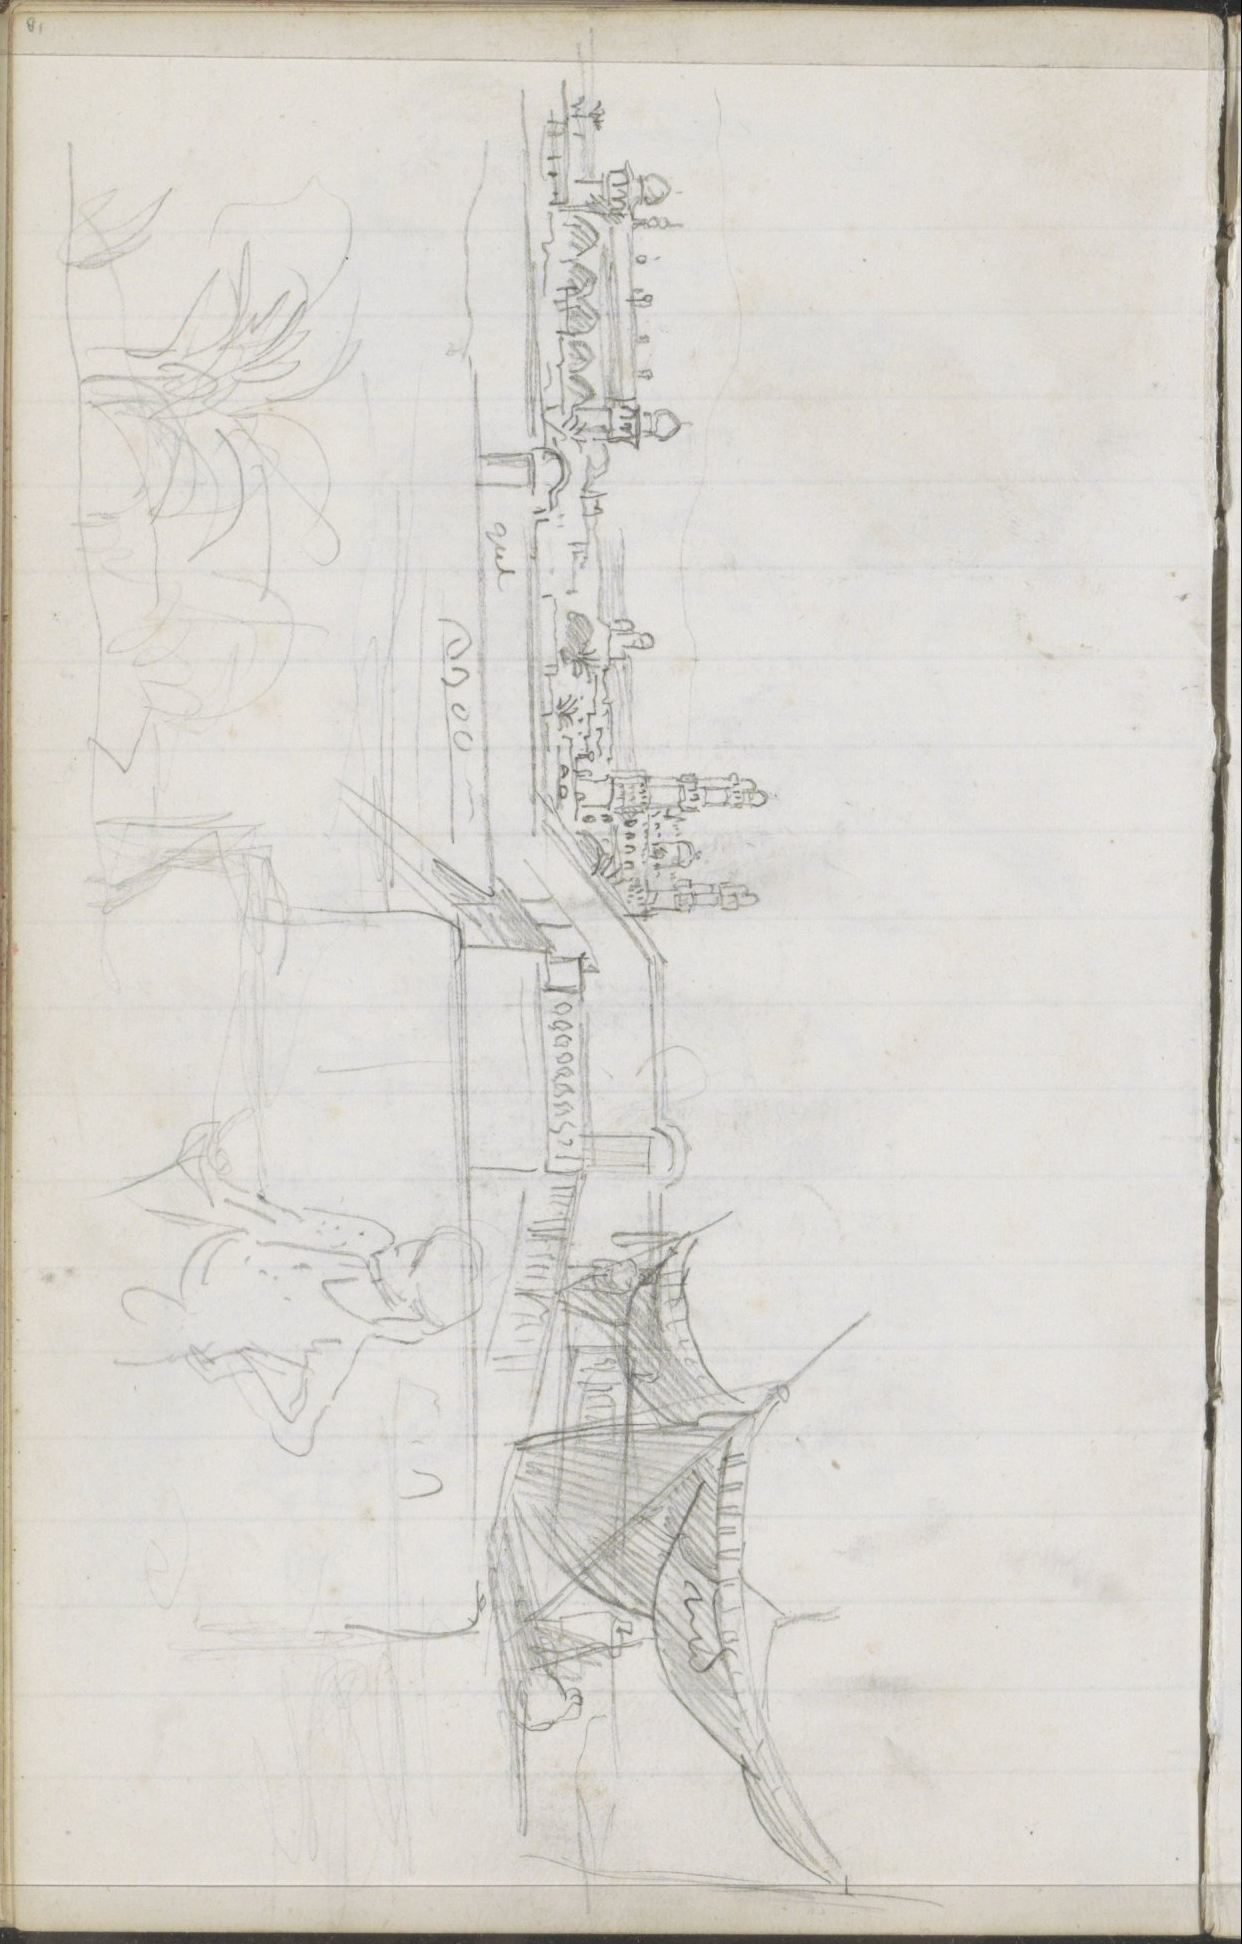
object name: sketchbook leaf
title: Hyderabad, gezien vanaf een balkon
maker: marius bauer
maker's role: draughtsman, print maker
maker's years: 1867-1932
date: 1897-1898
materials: pencil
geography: hyderabad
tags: city-view, and landscape with man-made constructions, balcony, temple, shrine ~ islam, mohammedanism, asiatic races and peoples: indians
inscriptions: kleurnotitie, handgeschreven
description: Op het balkon staat een Indiase man. Op de achtergrond zijn andere balkons te zien en de stad Hyderabad, met links de Makkah Masjid en in het midden de Charminar. Pagina 81 uit een schetsboek met 62 bladen.